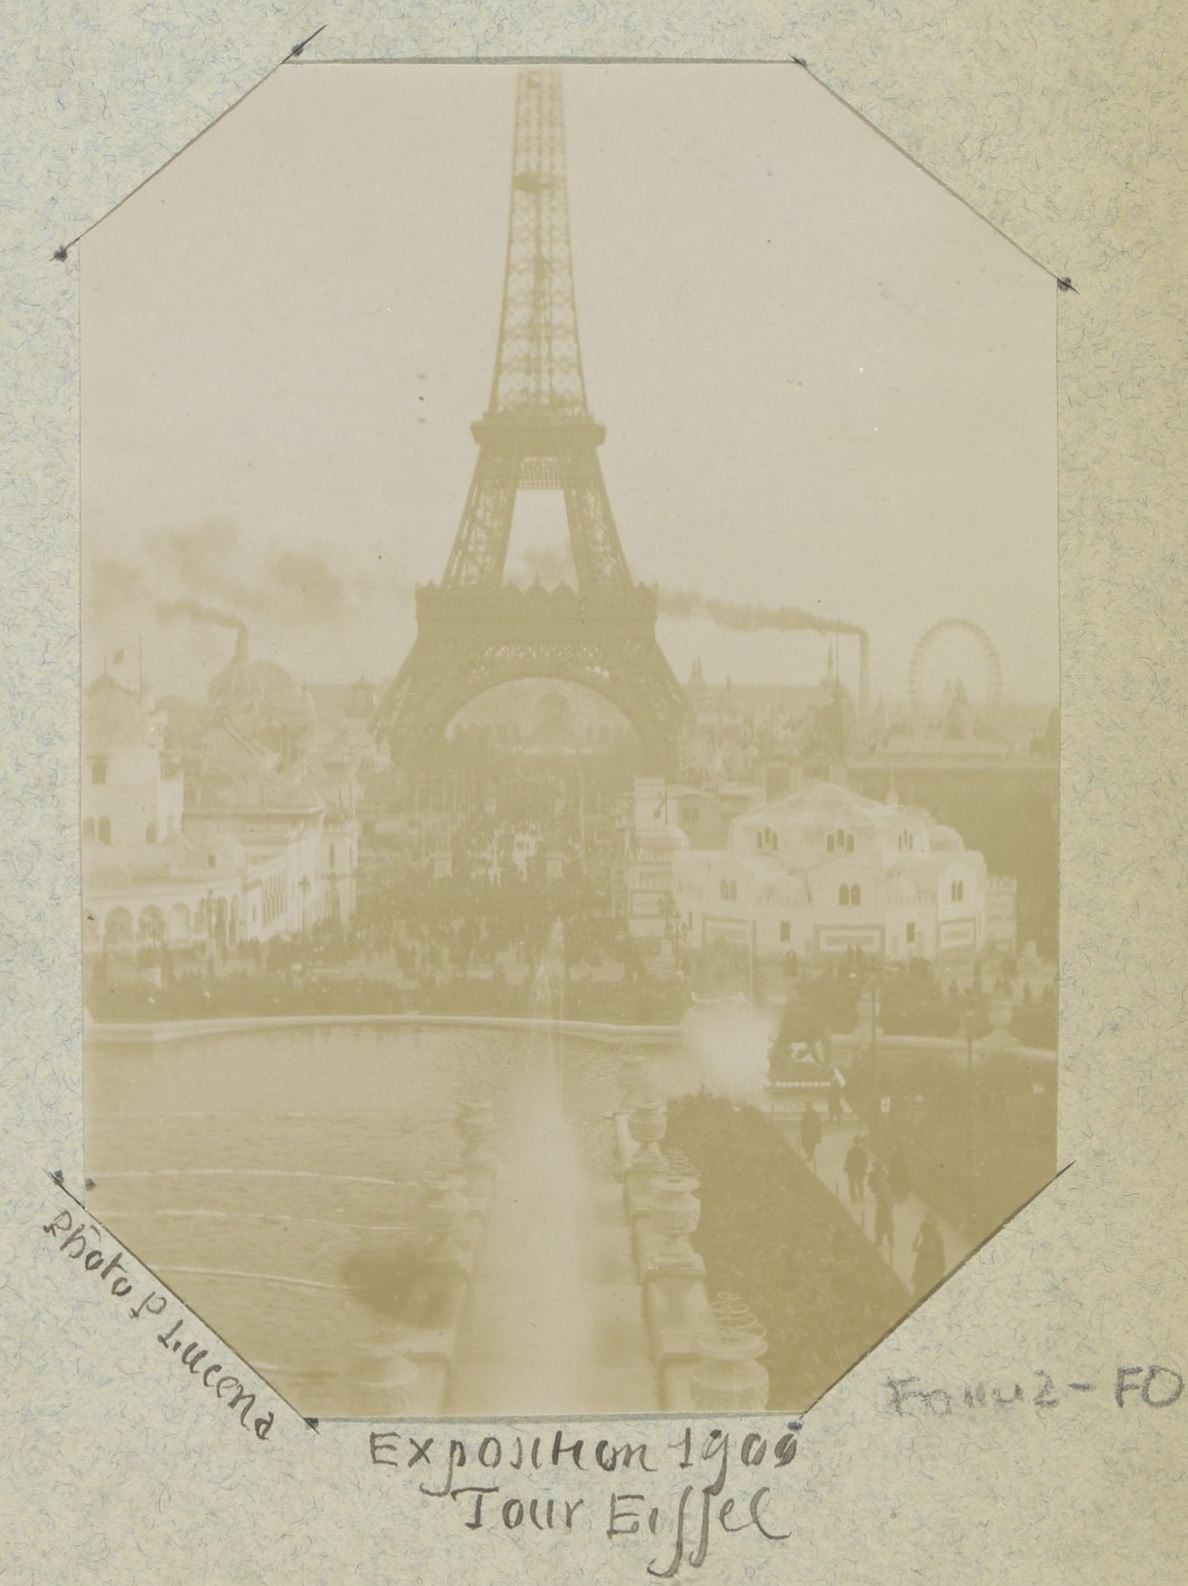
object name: photograph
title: Gezicht op de Eiffeltoren tijdens de Wereldtentoonstelling van 1900 met op de achtergrond rokende schoorstenen en een reuzenrad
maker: paul lucena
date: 1900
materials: paper, photographic support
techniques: daylight paper print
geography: paris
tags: smoke-stack, world fair, world exhibition, giant wheel, ferris wheel, paris, eiffel tower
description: Onderdeel van Album van een Franse amateur met foto's van Frankrijk, Algerije, Palmyra, de Wereldtentoonstelling van 1900 en van bekende Fransen.